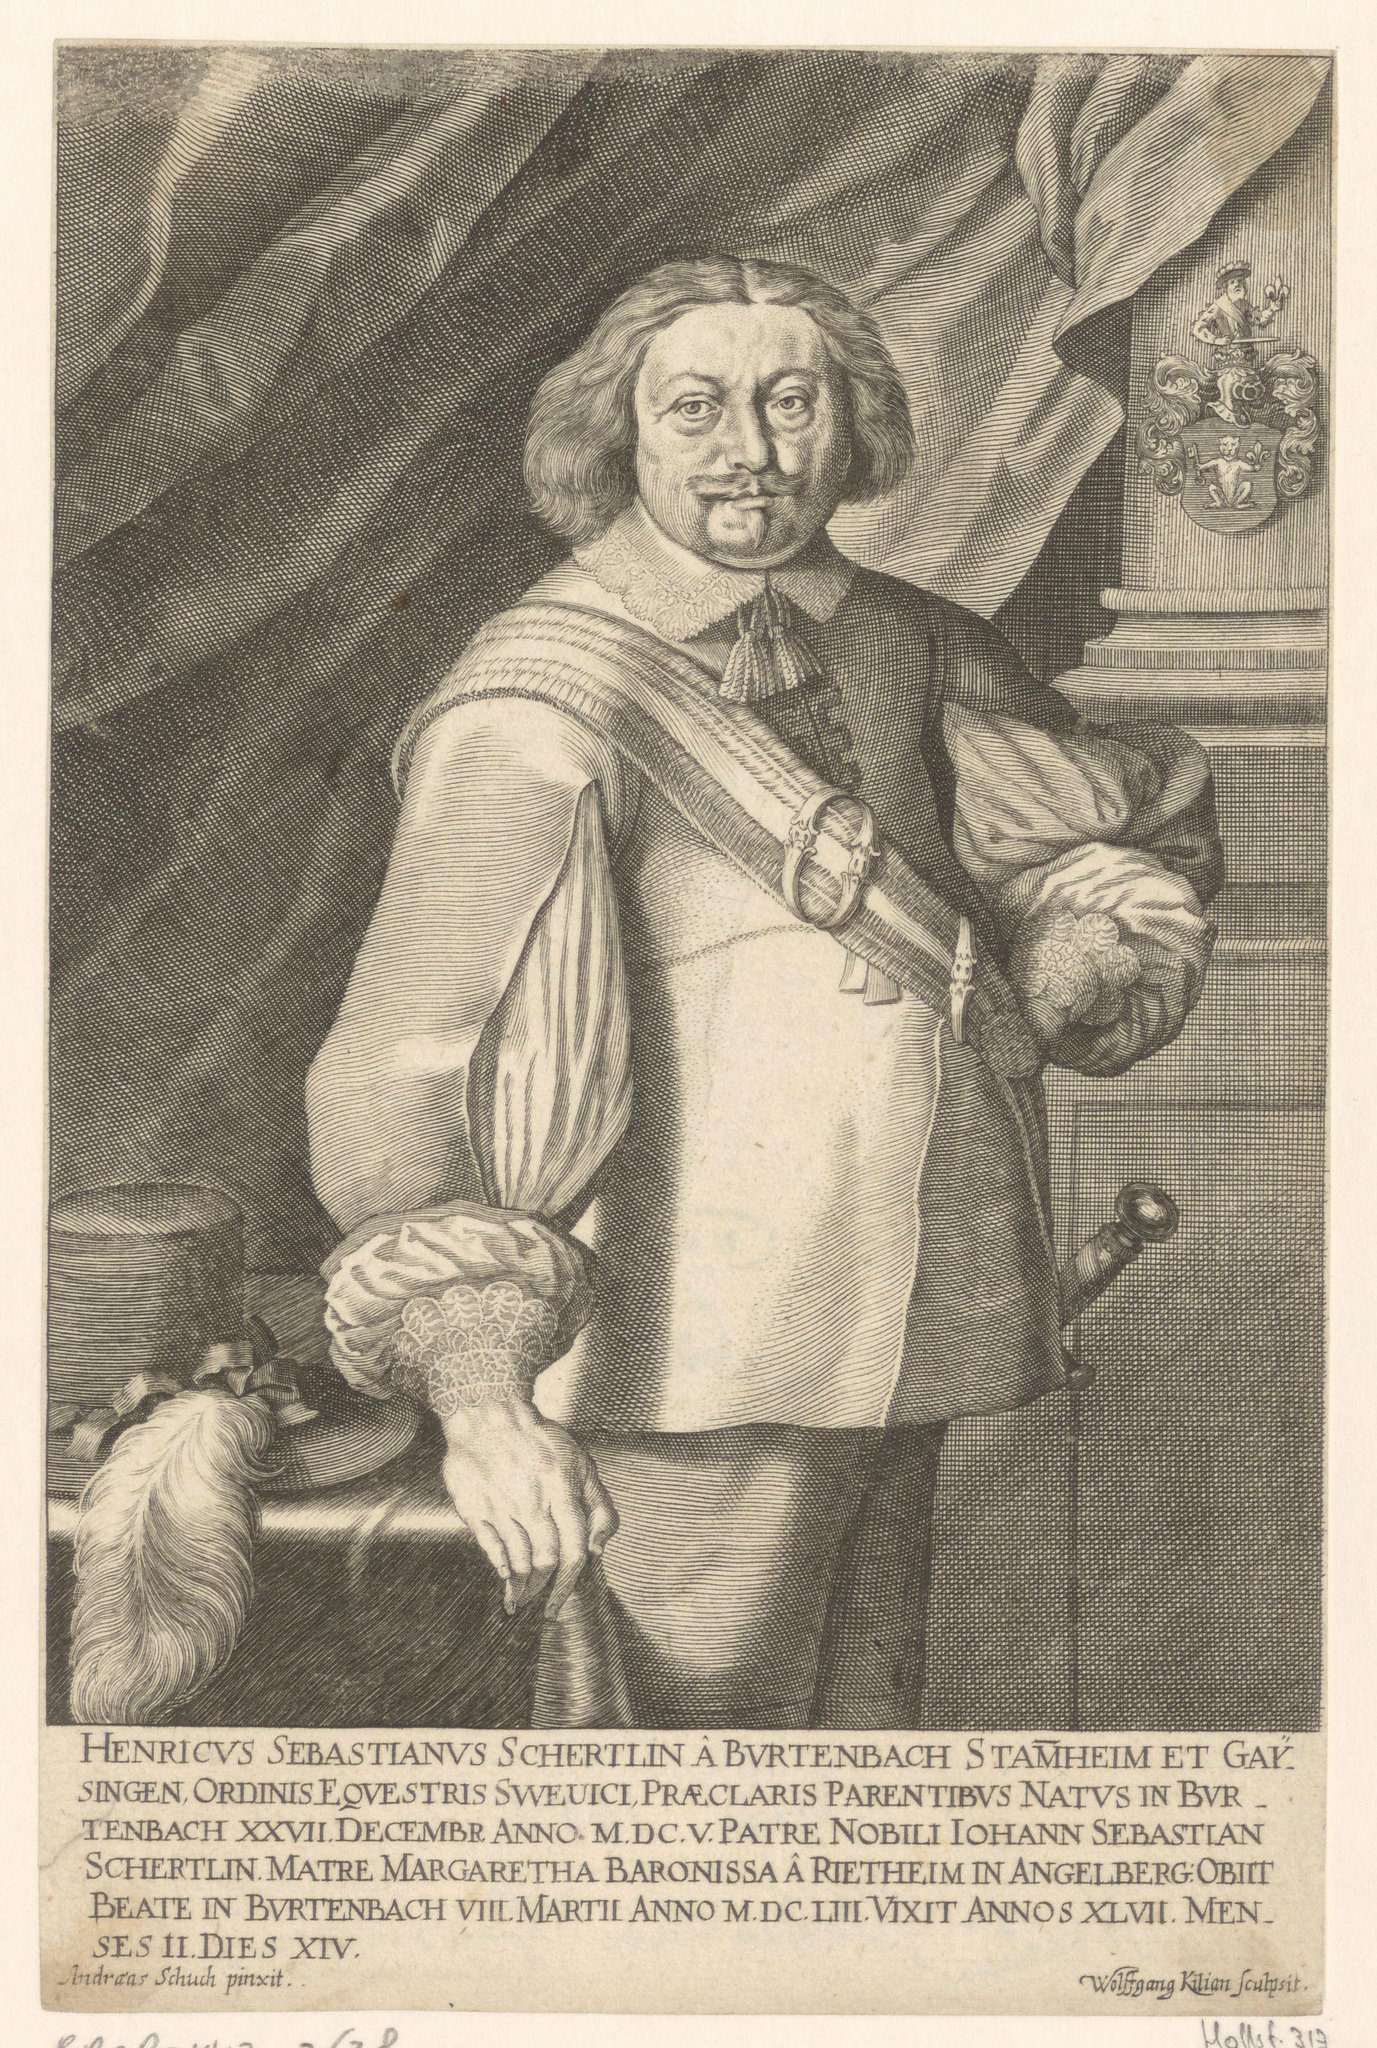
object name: print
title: Portret van Heinrich Sebastian Schertlin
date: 1653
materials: paper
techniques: engraving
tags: historical persons, knight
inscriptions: collector's mark: Lugt 2228